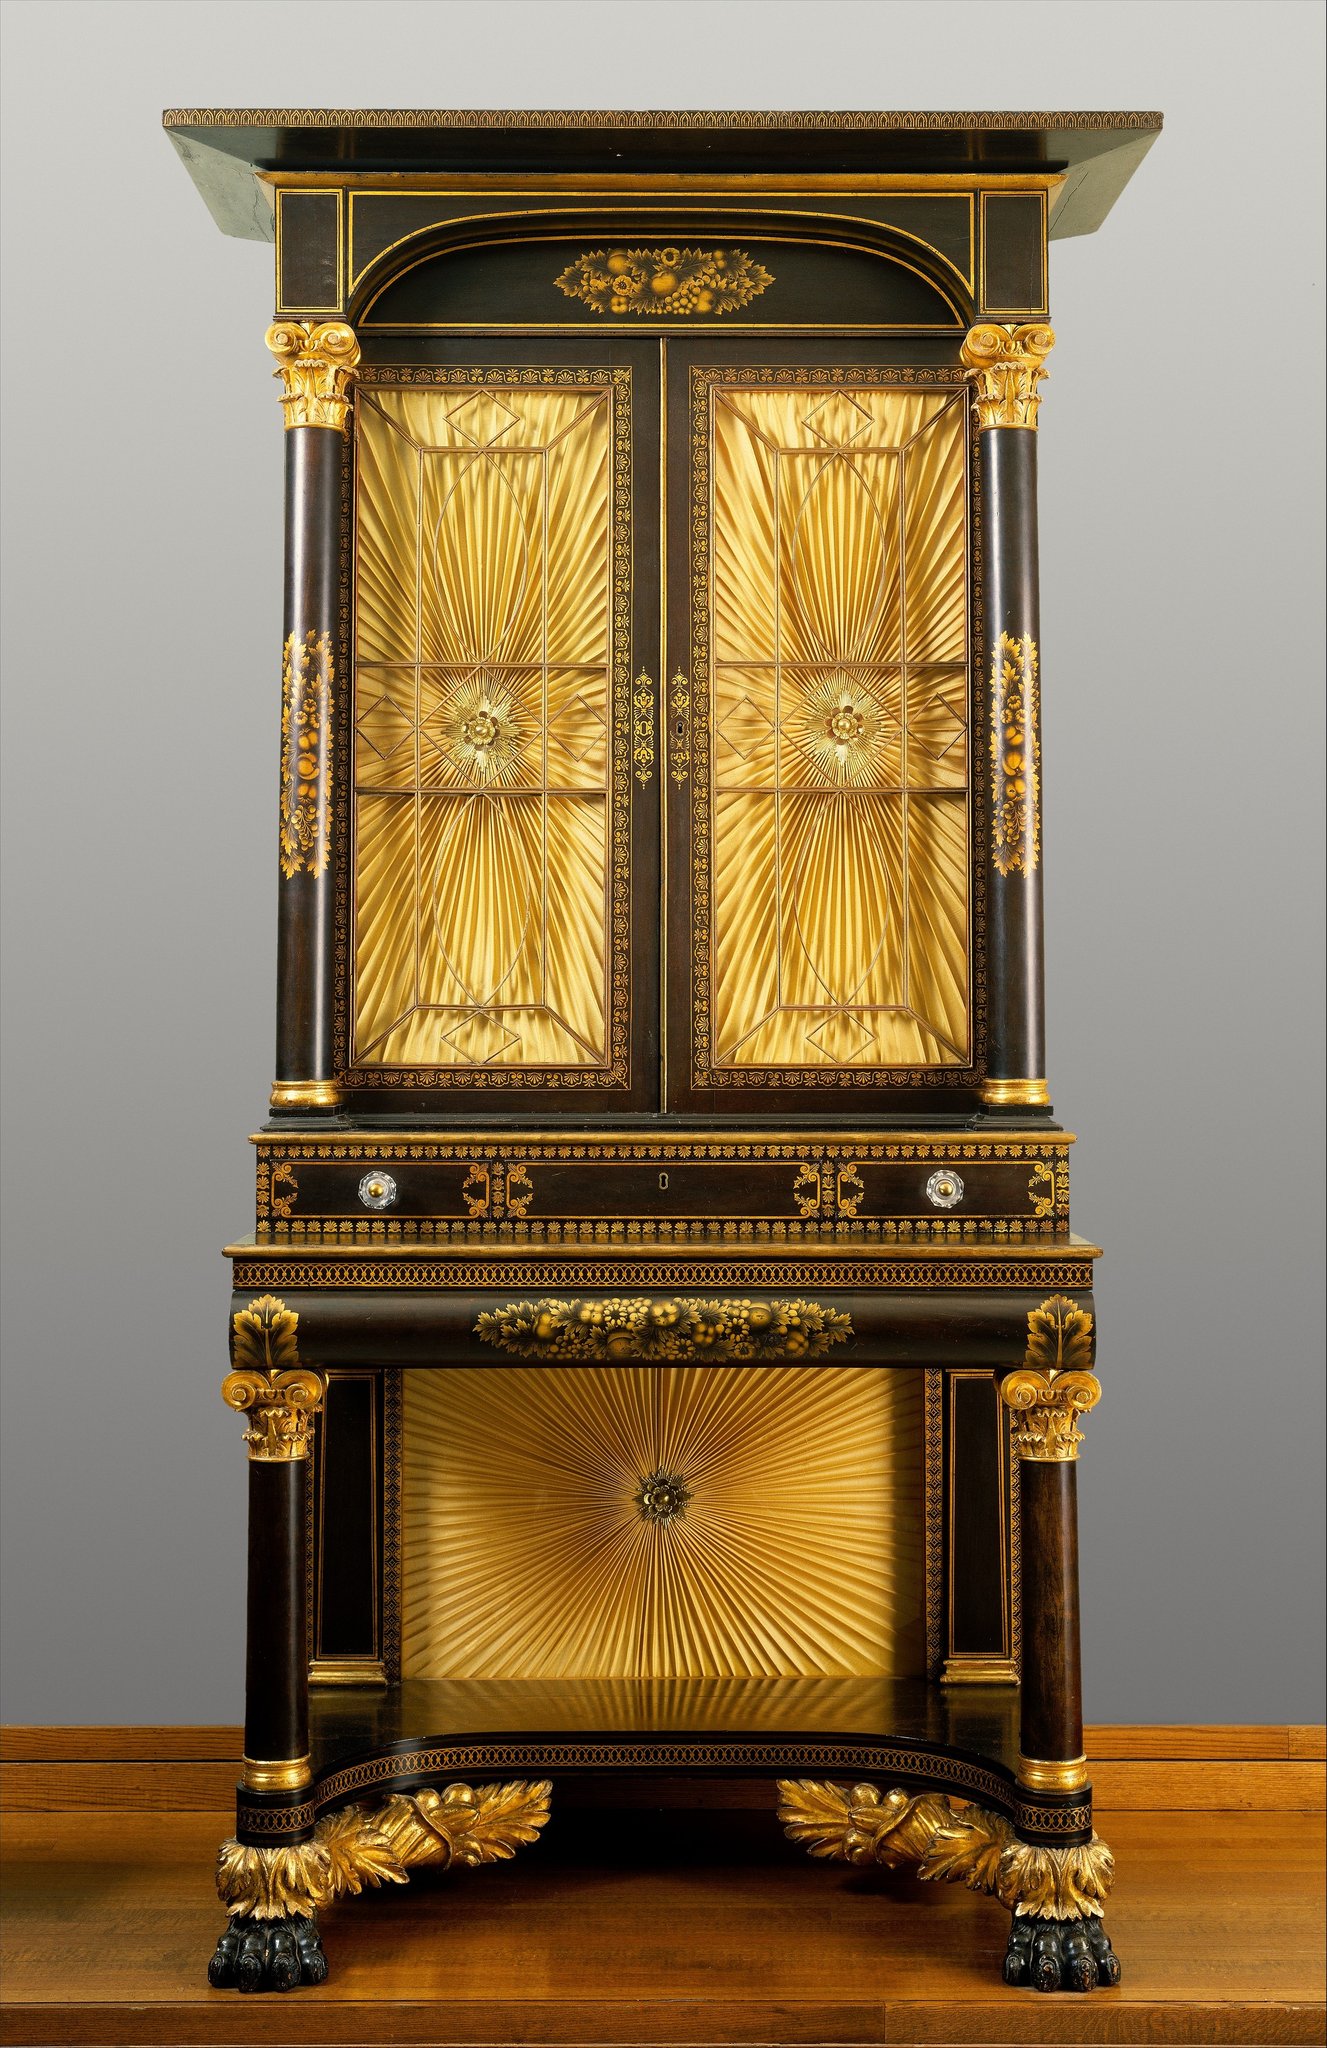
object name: secretary and bookcase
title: Secretary-bookcase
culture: american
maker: robert fisher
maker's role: maker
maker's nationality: american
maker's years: 1824-1837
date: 1825-1835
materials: brass, glass, wood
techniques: gilding, stamping, veneering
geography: united states